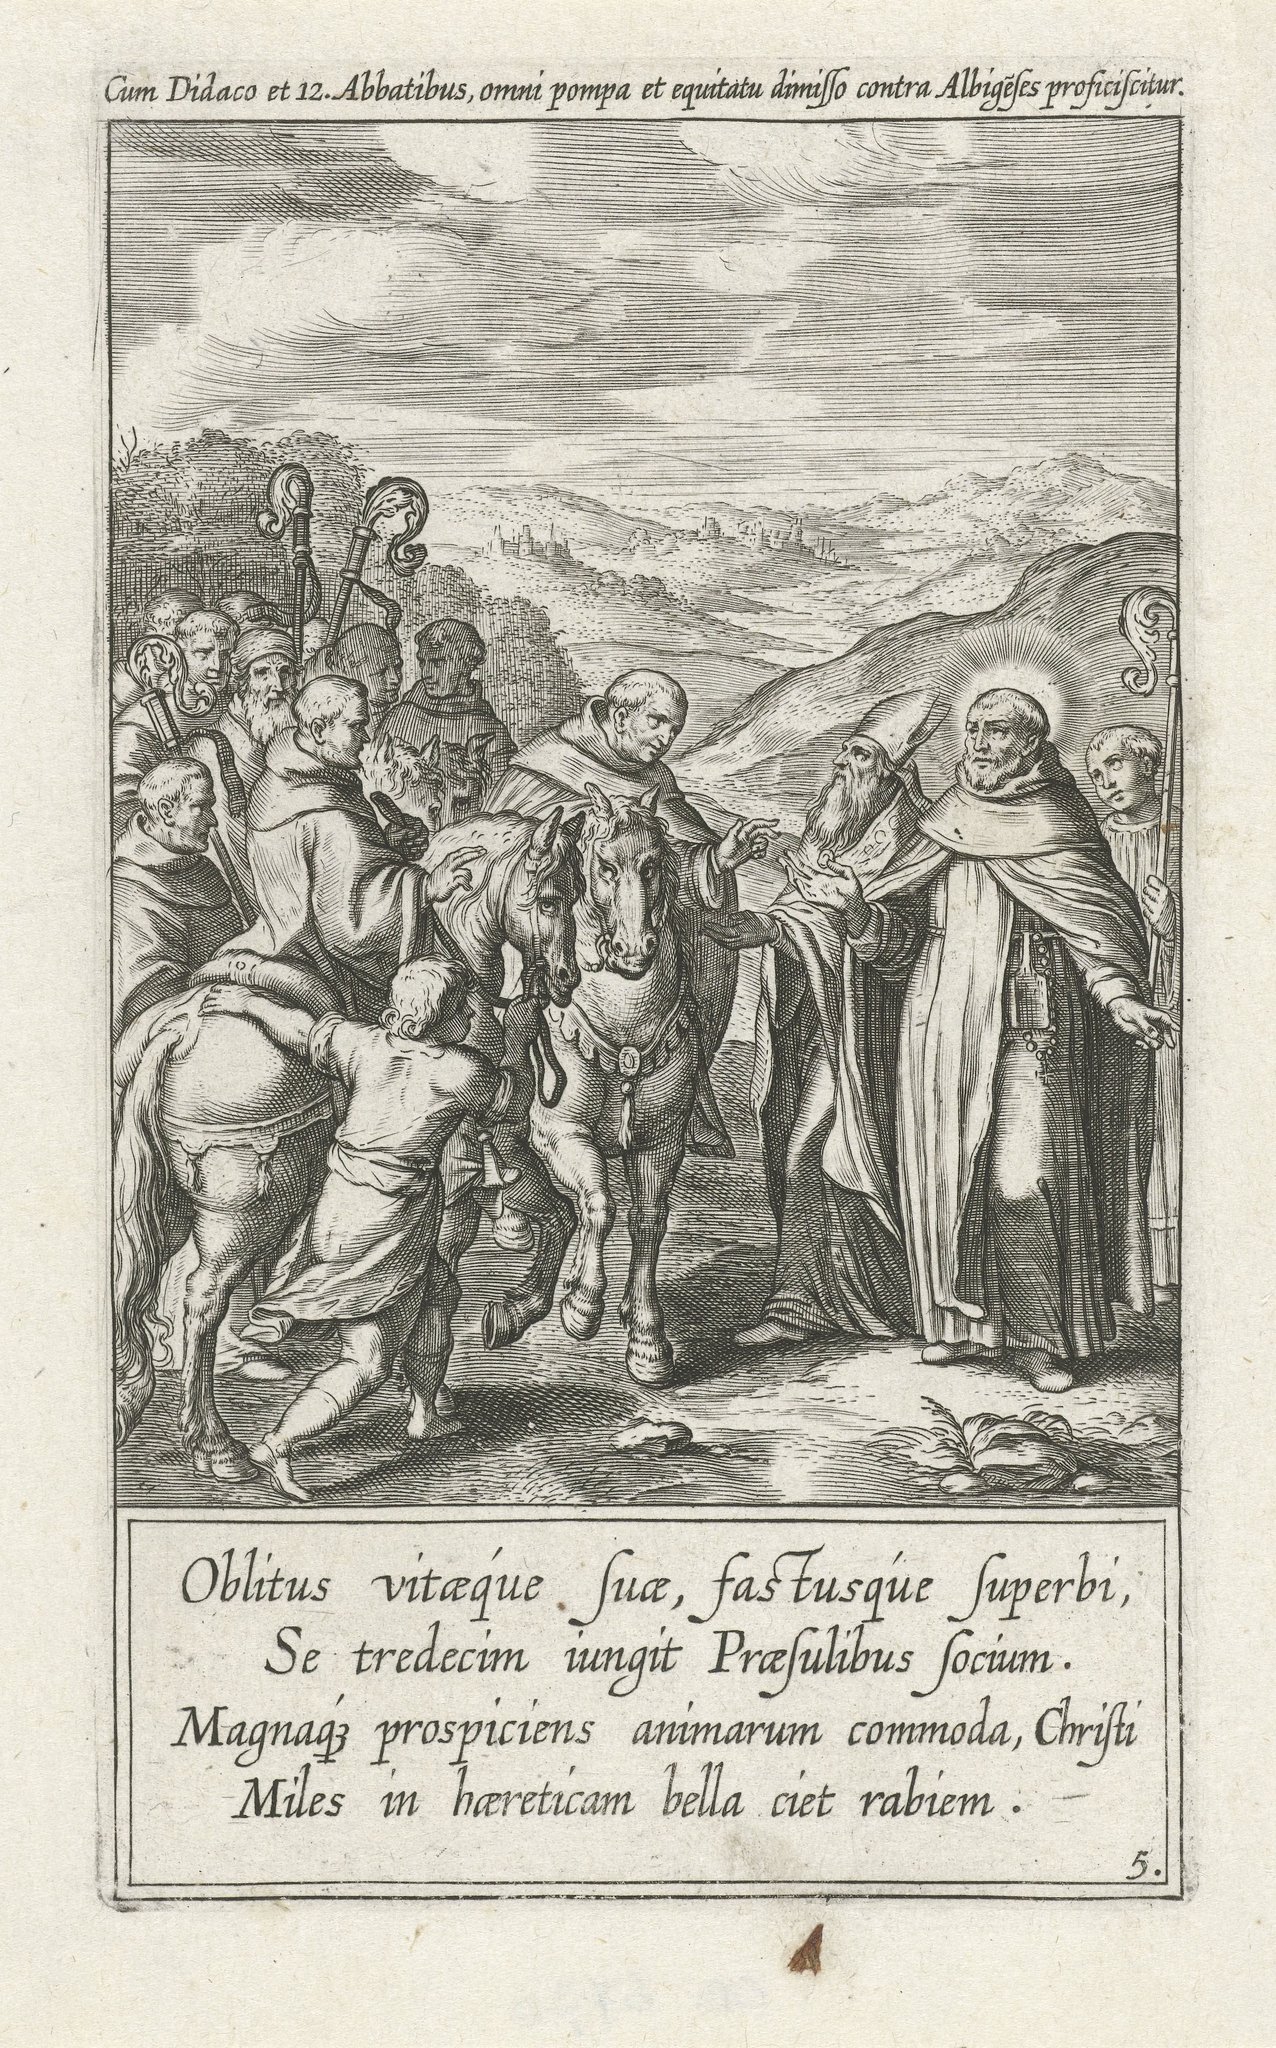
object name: print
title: Ontmoeting tussen de Heilige Dominicus en de cisterciënzer monniken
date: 1611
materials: paper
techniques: engraving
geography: antwerp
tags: dominic(us) guzman of calerueja, founder of the order of preachers (or dominican (black) friars; possible attributes: book, dog with flaming torch, lily, loaf of bread, rosary, star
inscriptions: collector's mark: Lugt 2228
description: De Heilige Dominicus ontmoet de cisterciënzer monniken en biedt zijn hulp aan in de strijd tegen de ketterse Albigenzen. De prent heeft een Latijns opschrift en onderschrift en maakt deel uit van een prentserie voor een boek over het leven van de heilige Dominicus.